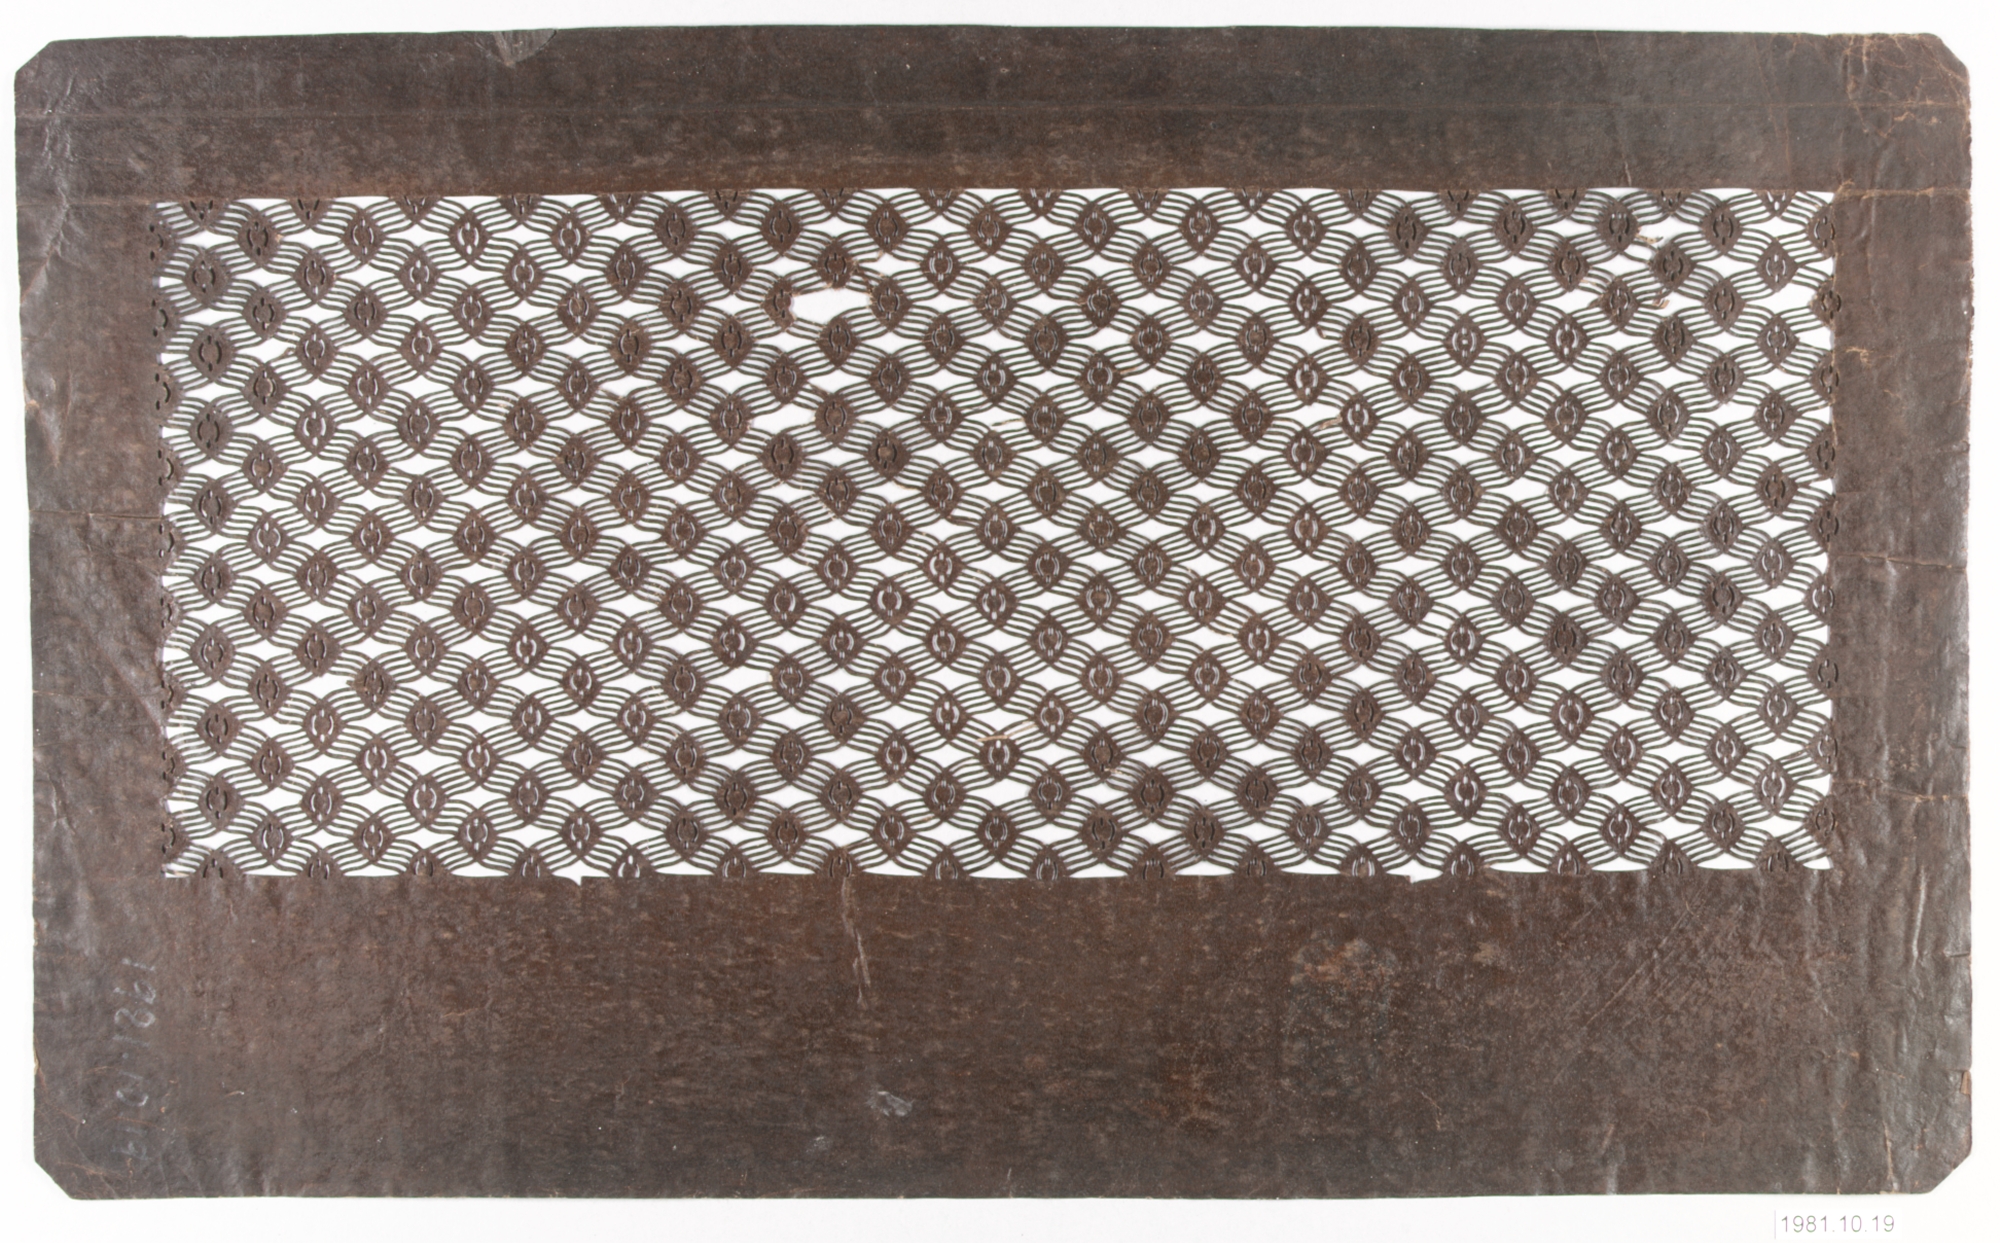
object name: stencil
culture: japanese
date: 1801-1900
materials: paper